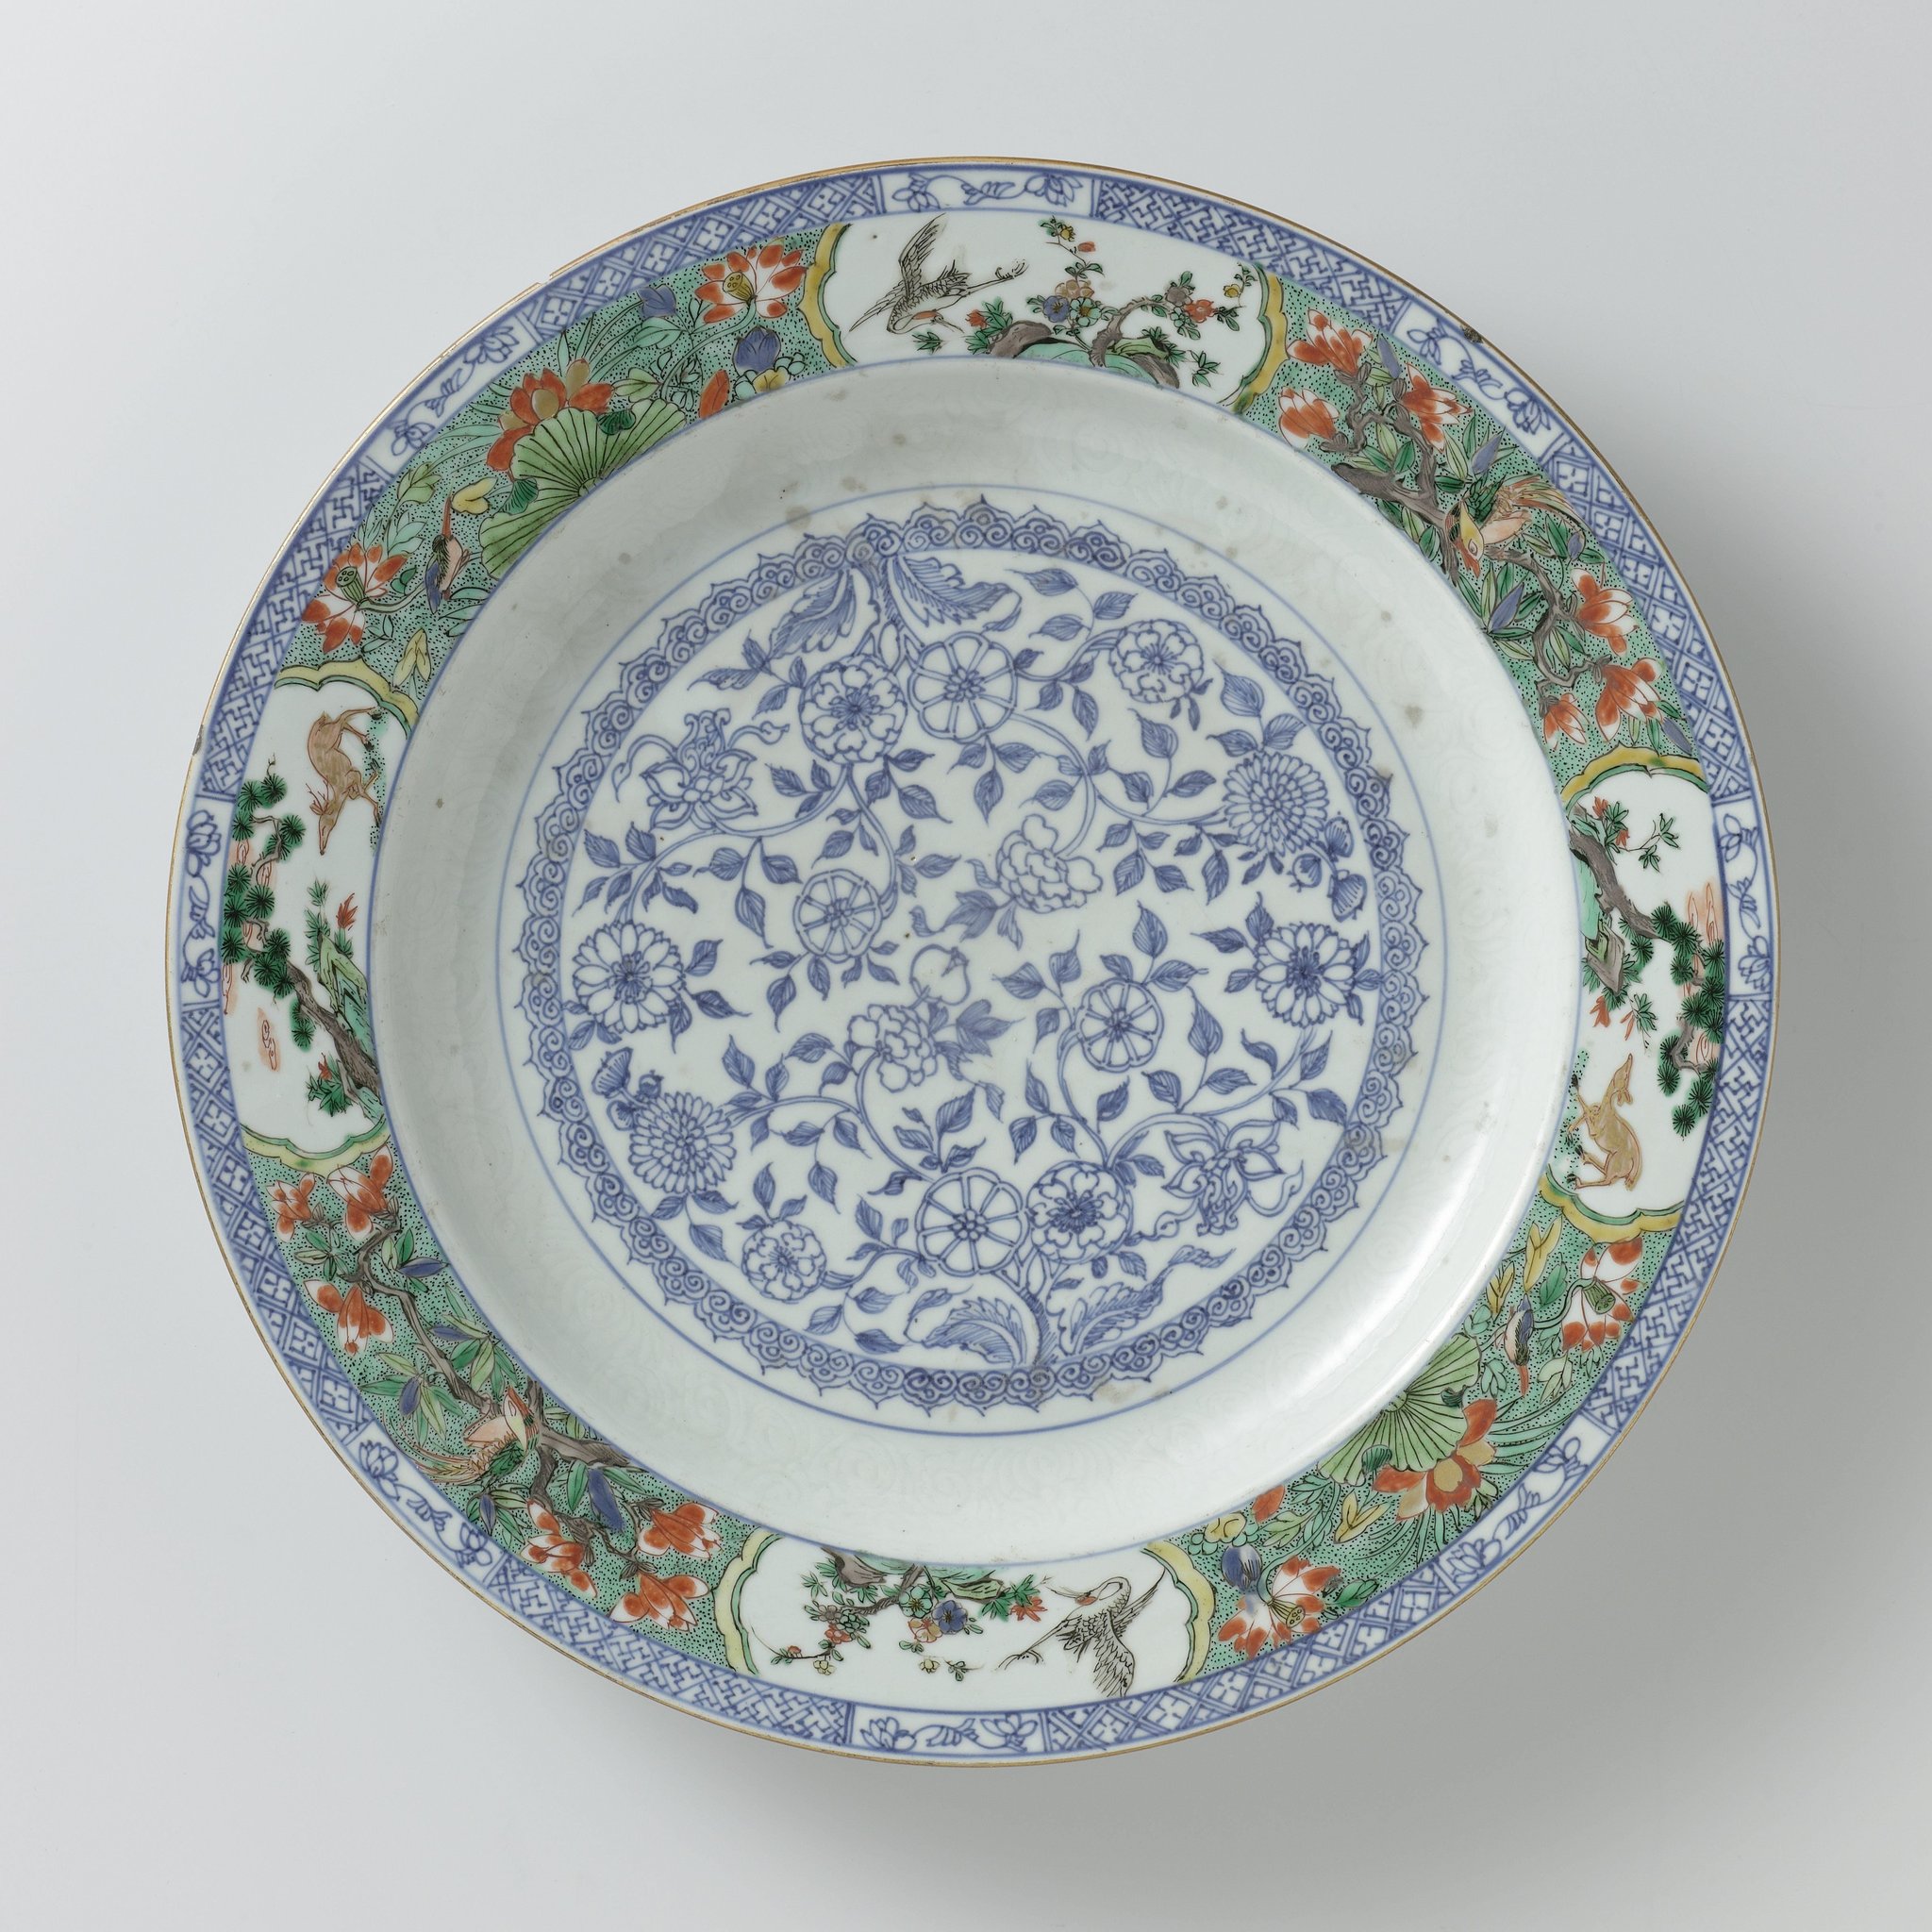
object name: platter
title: Dish with stylised flower scrolls, flower sprays and animals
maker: Anonymous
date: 1700-1724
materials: cobalt, glaze, gold, paint, porcelain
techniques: firing, turning, vitrification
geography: china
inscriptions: label: ‘8’, label: ‘6. 14/4/05’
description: Schotel, famille verte, met decoratie van twee bloemtakken binnen een jui-rand, met in vier uitgespaarde vakken twee maal een kraanvogel en tweemaal een hert, afgewisseld met vlakken gevuld met bloemen en vogels op groen met zwart gespikkelde grond.